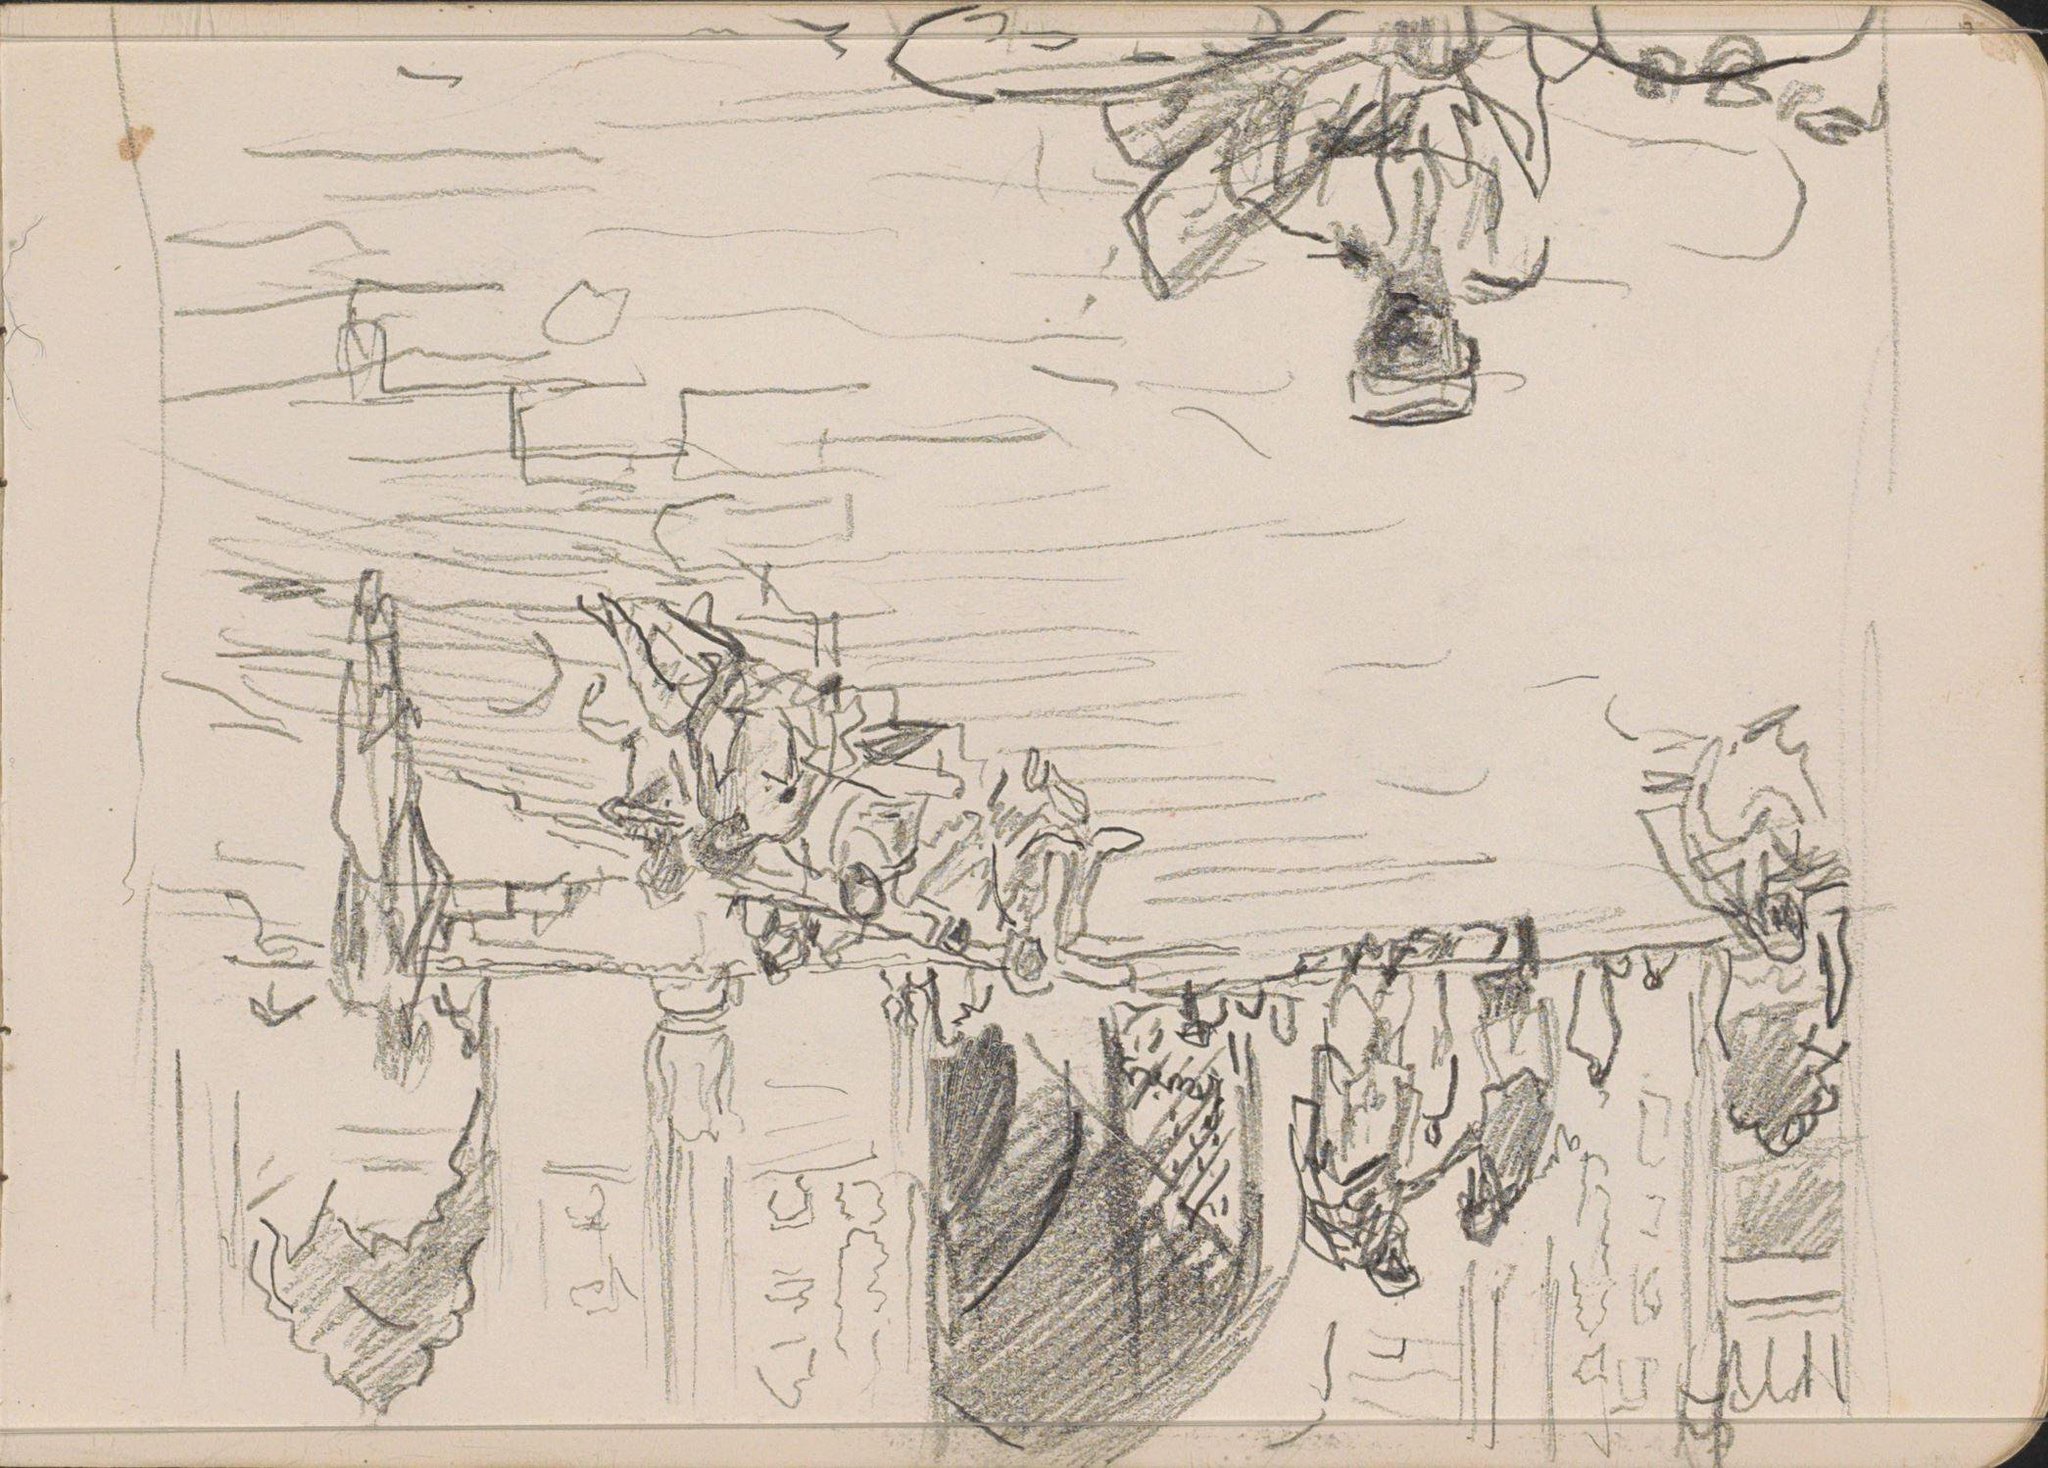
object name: sketchbook leaf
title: Figuren op de trappen van de Jama Masjid Moskee in Delhi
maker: marius bauer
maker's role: draughtsman, print maker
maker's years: 1867-1932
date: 1925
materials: paper, pencil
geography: delhi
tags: sitting figure, flight of steps, arch, archivolt ~ architecture, temple, shrine ~ islam, mohammedanism, asiatic races and peoples: indians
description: Pagina 13 uit een schetsboek met 15 bladen.